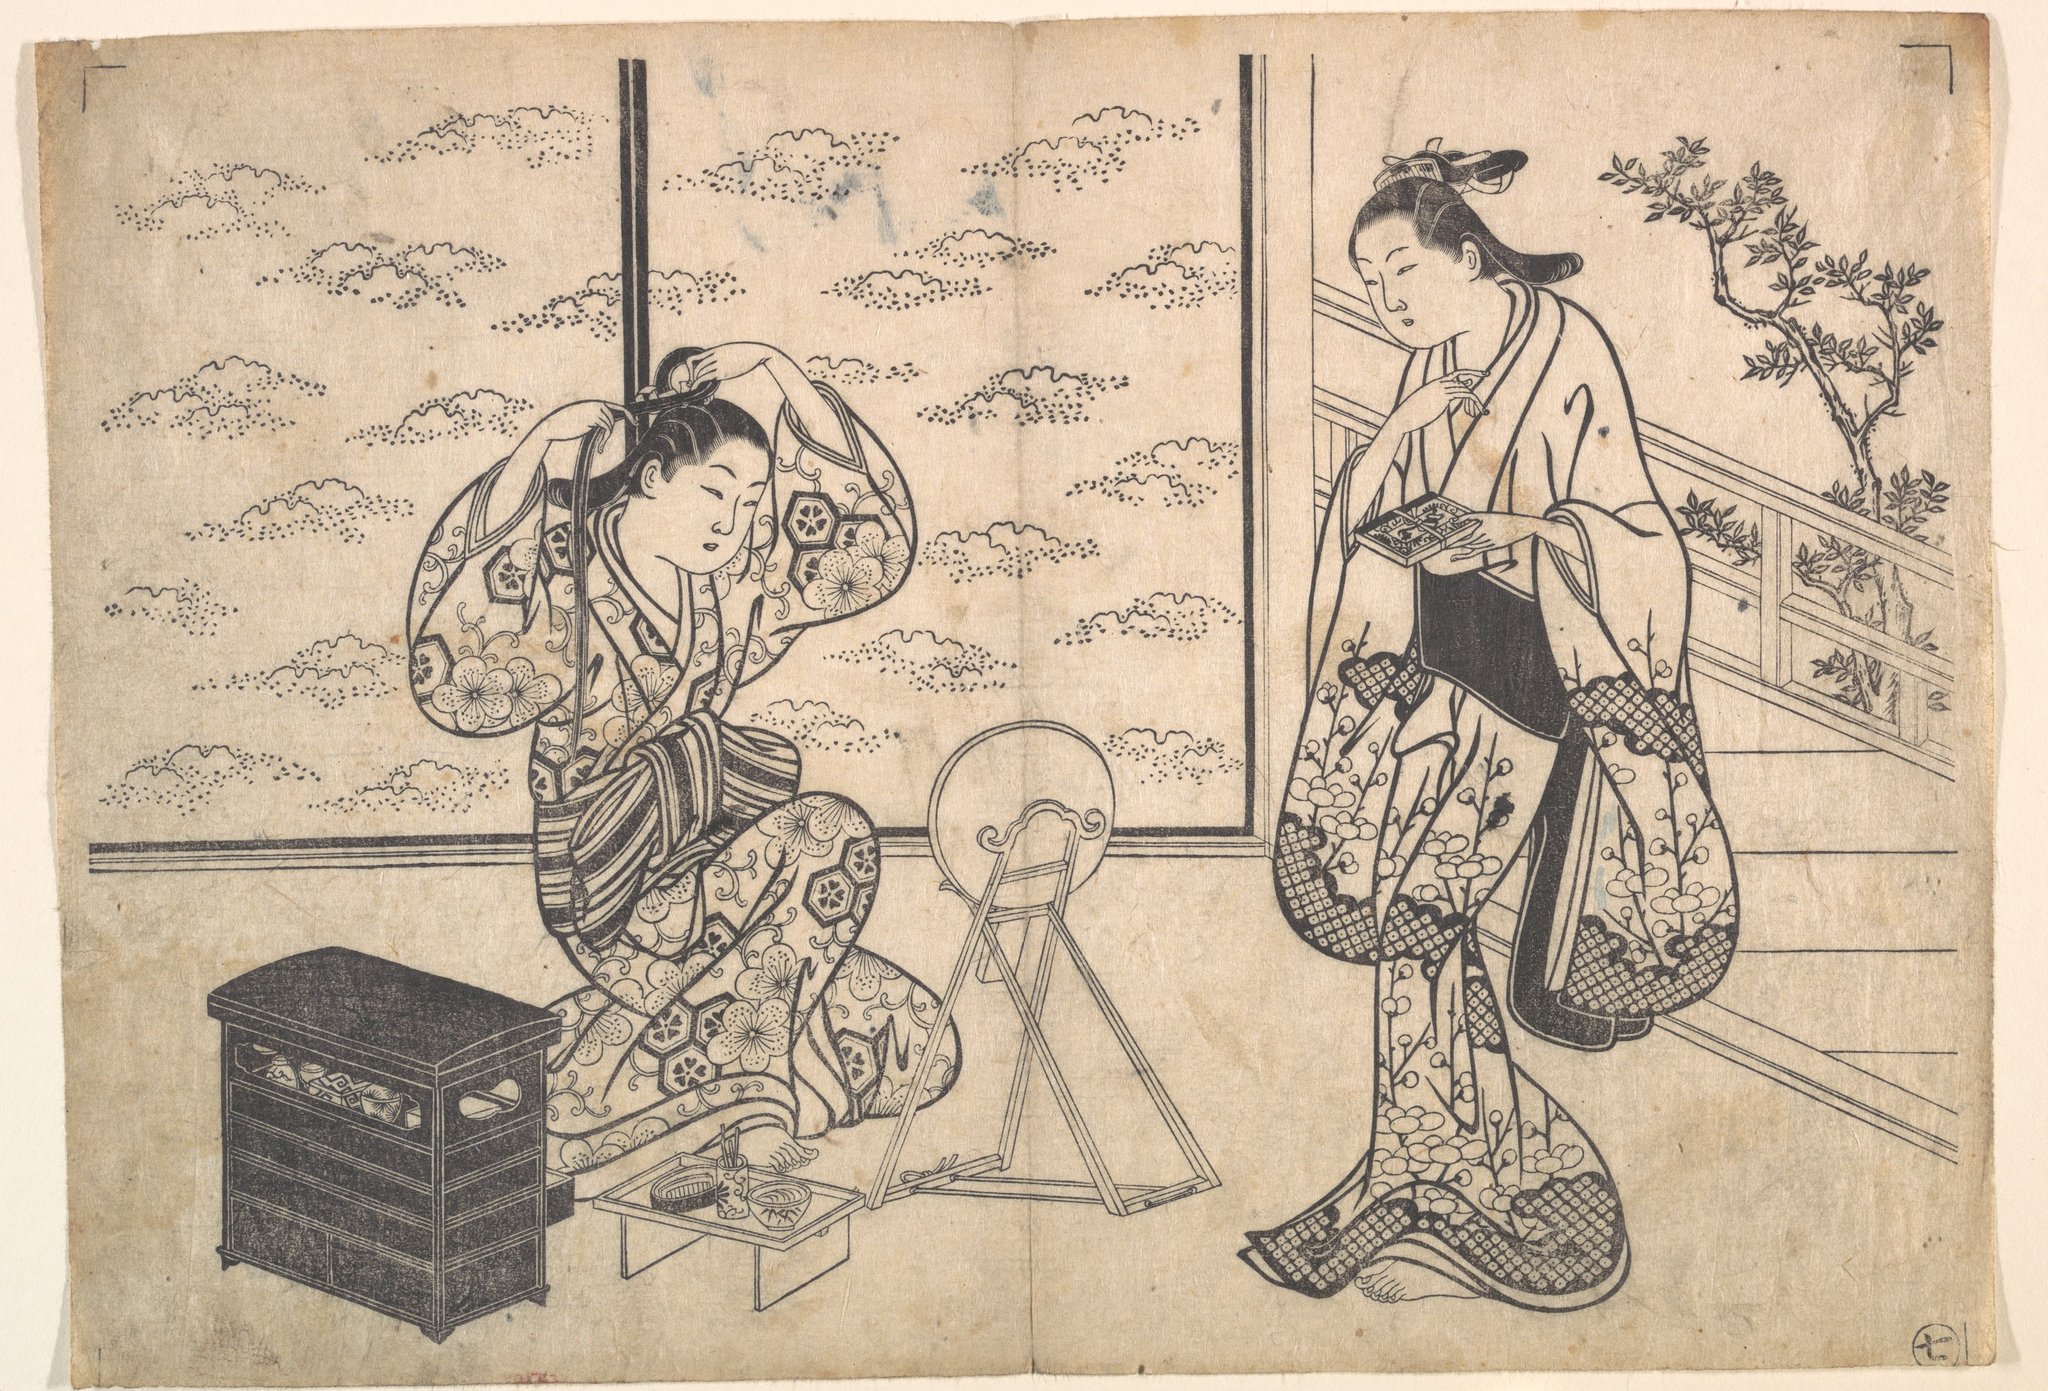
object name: print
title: Two Women in a Room Opening on a Verandah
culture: japanese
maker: hasegawa mitsunobu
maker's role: artist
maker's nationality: japanese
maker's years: 1724-1754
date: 1730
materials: ink, paper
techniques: woodblock print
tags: women,mirrors